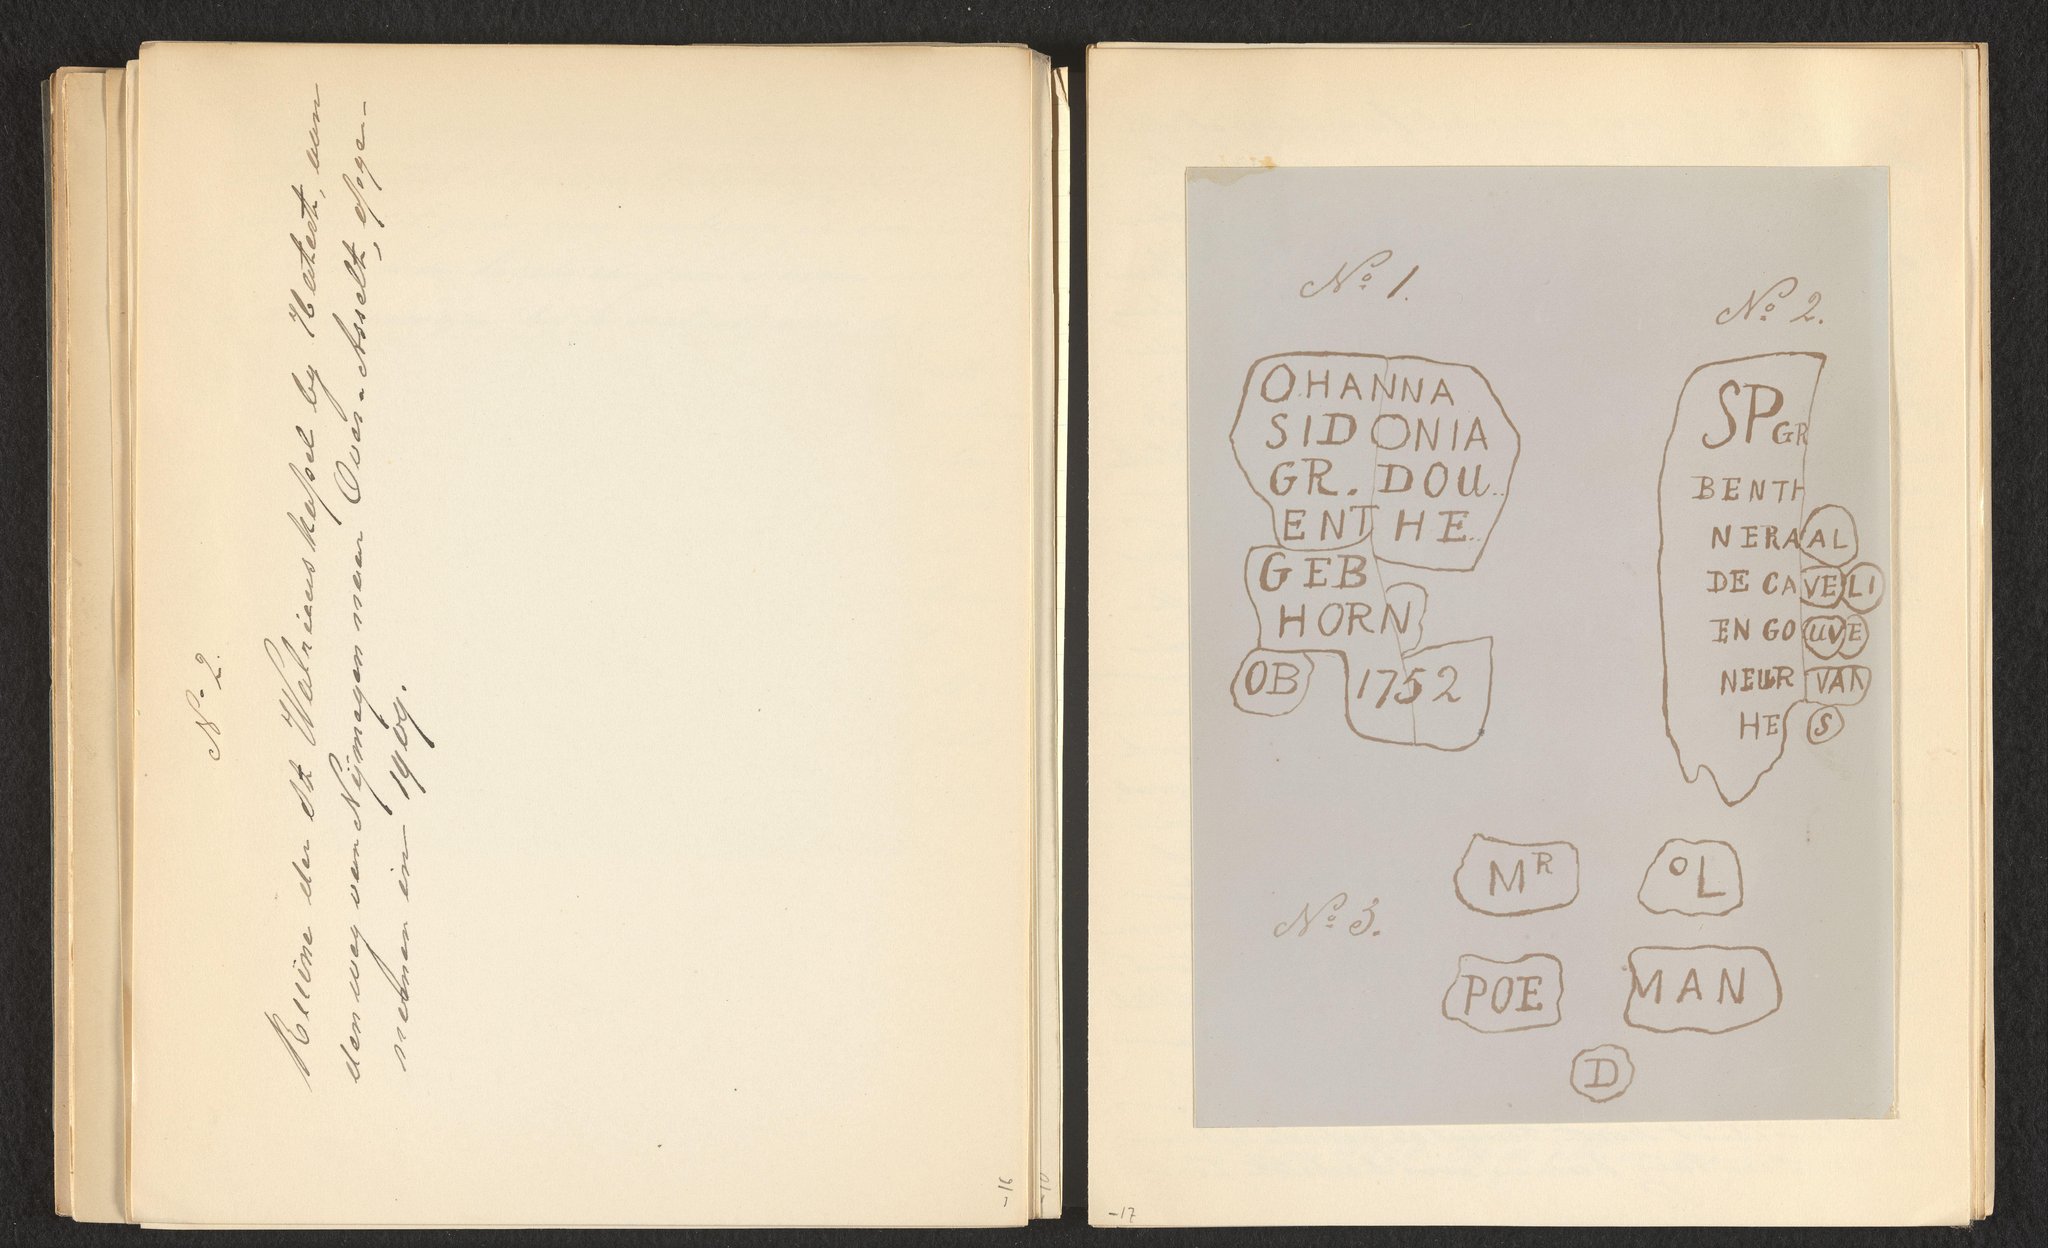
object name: photograph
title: Fotoreproductie van tekeningen naar tekens op de graven van Johanna Sidonie van Horne en Statius Philips van Bentheim in de Oude Sint-Victorkerk in Batenburg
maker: benjamin charlé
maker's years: 1845-1925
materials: paper, cardboard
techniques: collodion silver print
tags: grave, tomb and other grave-forms and grave-markers